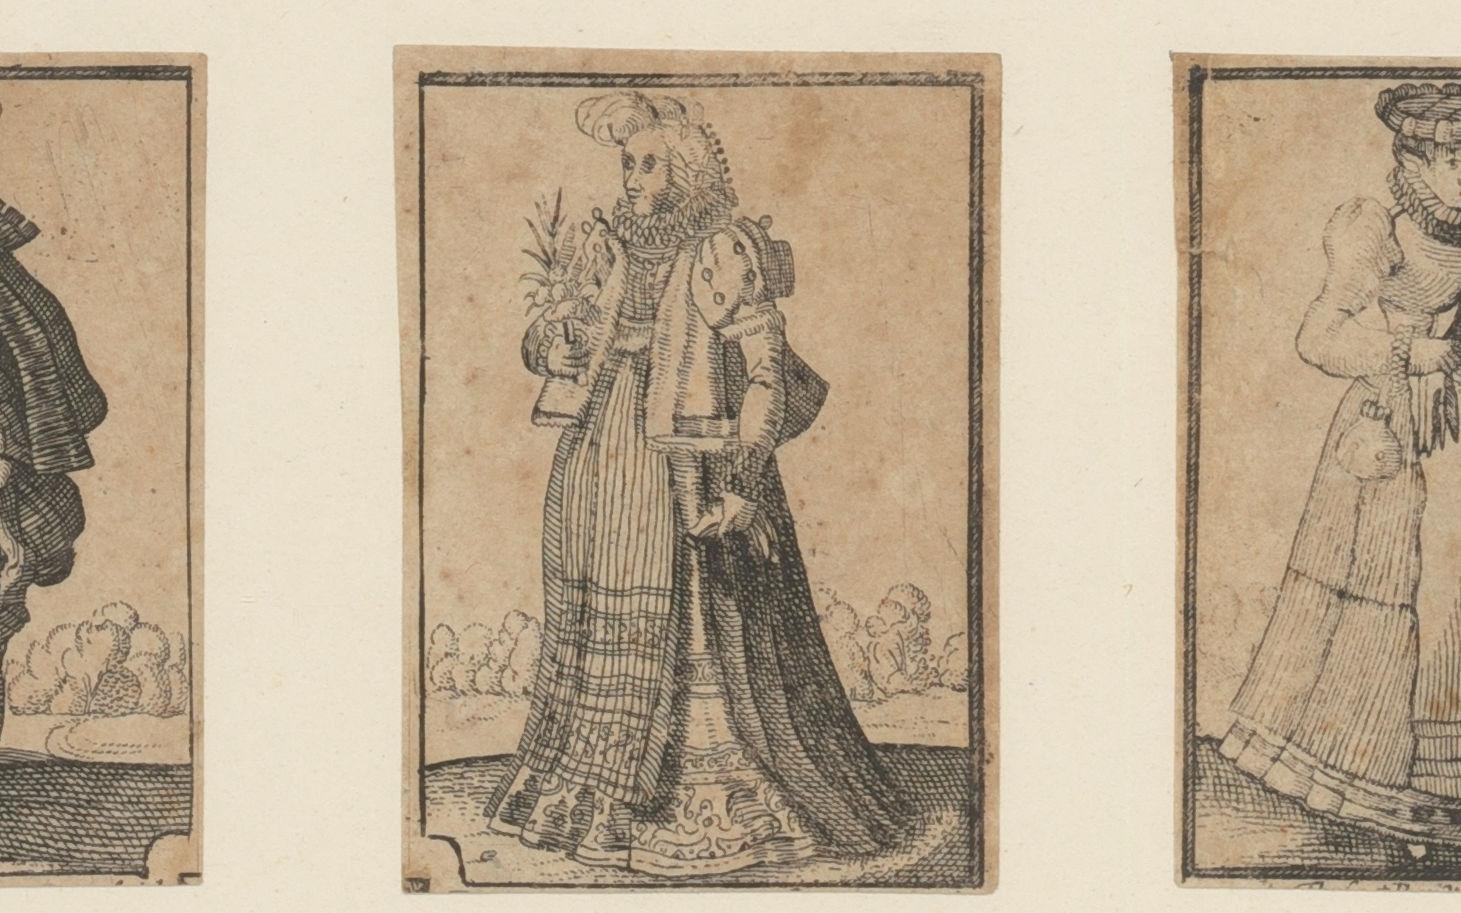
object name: print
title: Staande vrouw met bloemen en een handschoen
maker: Anonymous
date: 1600-1699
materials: paper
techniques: etching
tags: gloves, mittens, etc., folk costume, regional costume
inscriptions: collector's mark: Lugt 1641, stamp, stamp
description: Onderwerpsrubrieken binnen de Atlas Zeden en Gewoonten: Zeden en Gewoonten in Engeren Zin, De Kleeding, Kleederdrachten (tijdvakken), De Spaansche tijd. (1550 – 1600).